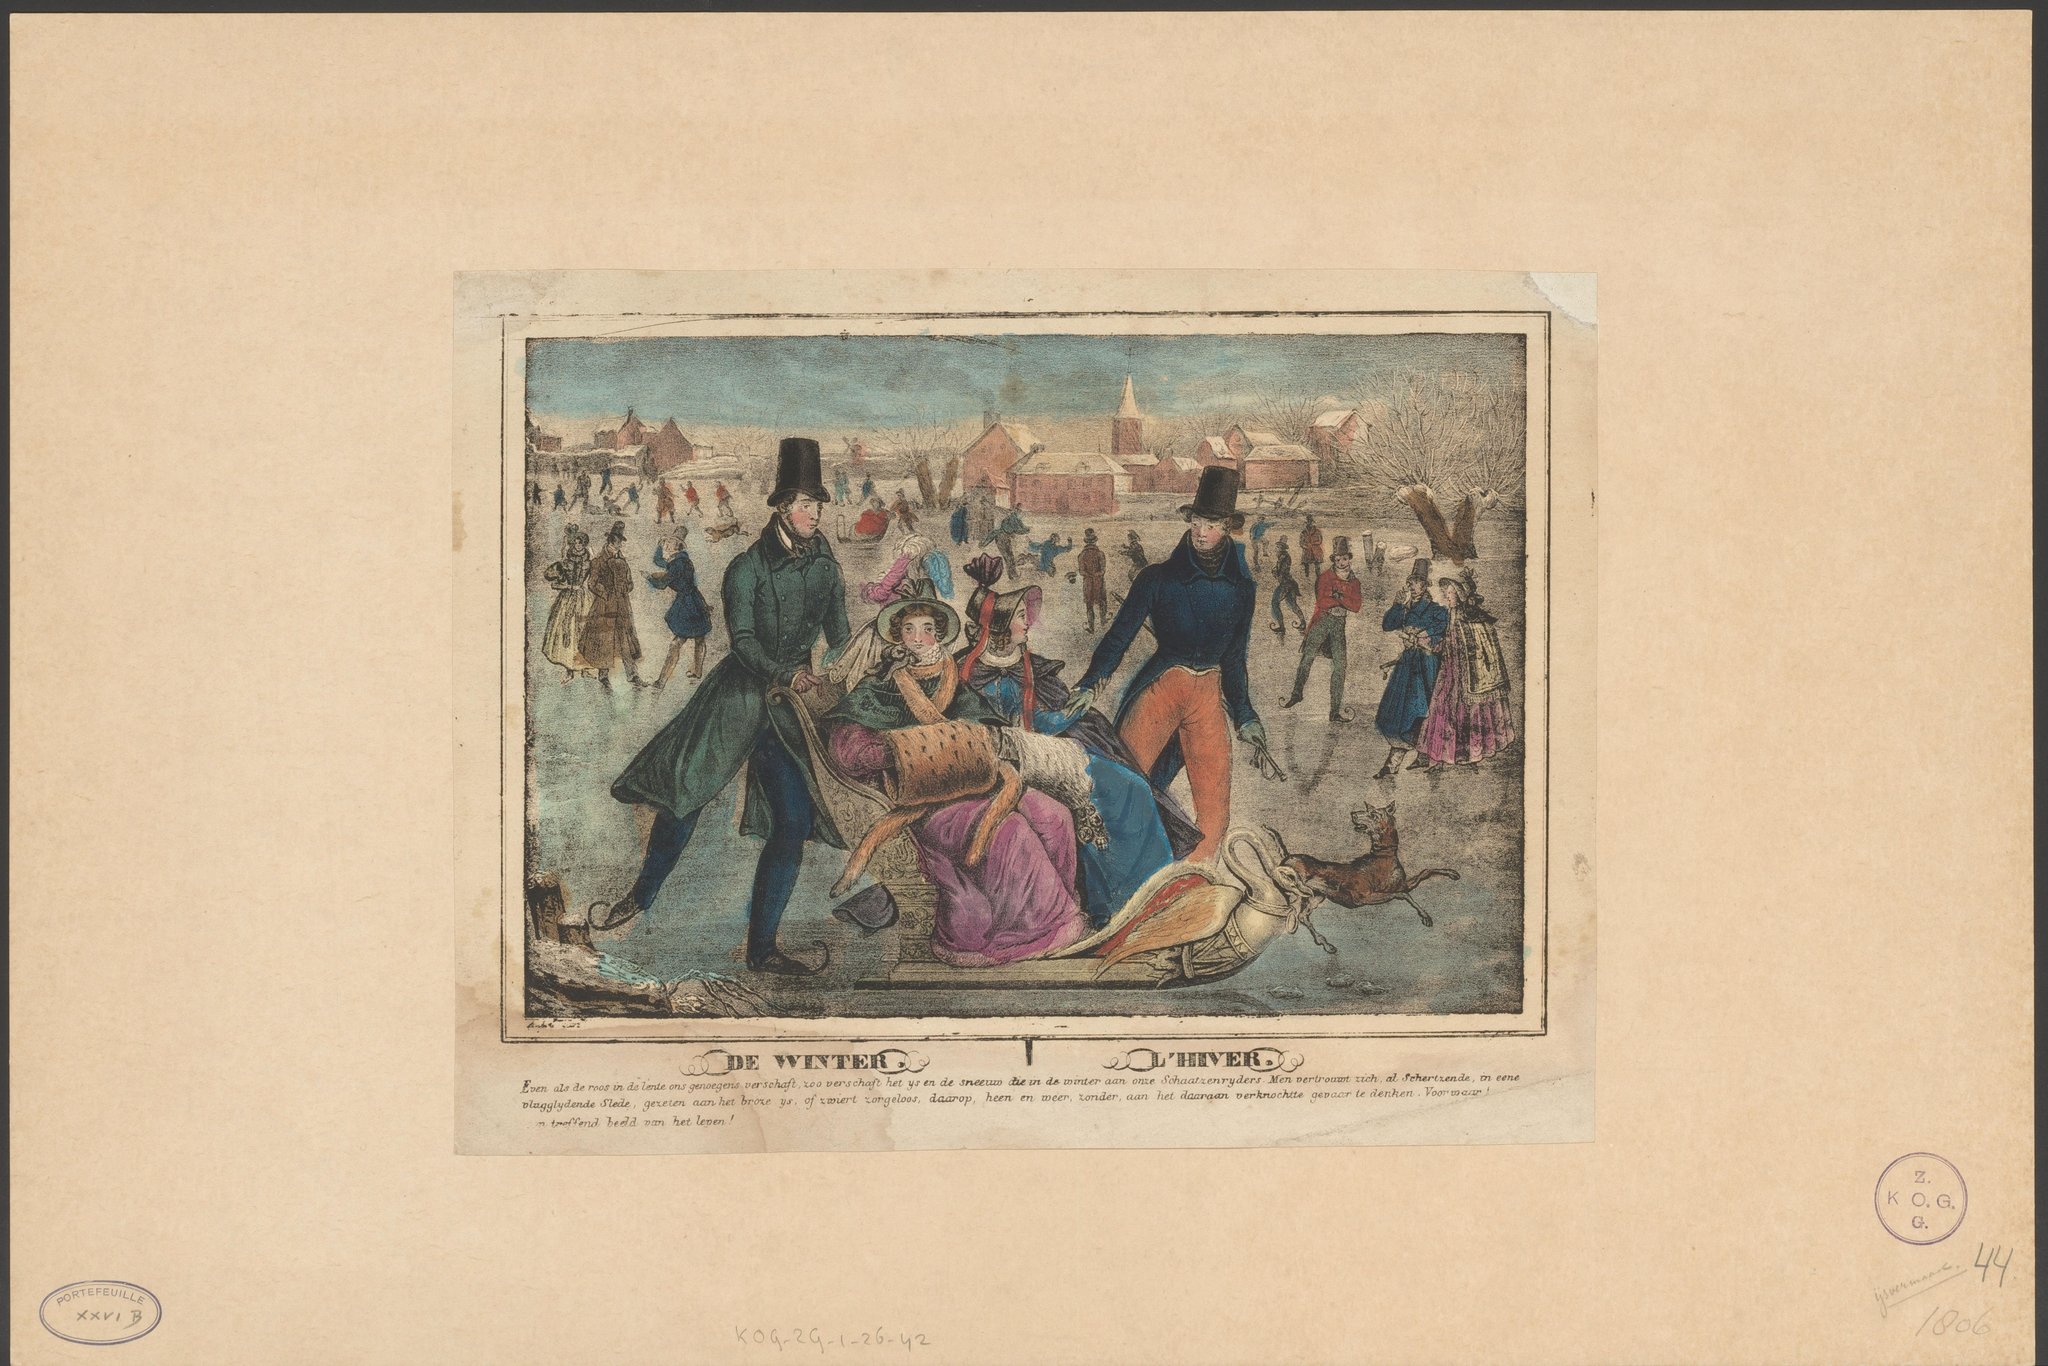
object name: print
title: De Winter / L'Hiver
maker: Anonymous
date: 1800-1899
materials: paper, watercolor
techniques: hand coloring, lithograph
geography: netherlands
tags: horse-sleigh, winter sports, skates (winter sports)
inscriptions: collector's mark, collector's mark: Lugt 1641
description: IJsvermaak in de winter. Op de voorgrond twee vrouwen in een arrenslee. Met onderschrift van drie regels in het Nederlands. Onderwerpsrubrieken binnen de Atlas Zeden en Gewoonten: Spel en Vermaak; IJsvermaak, Sleden.